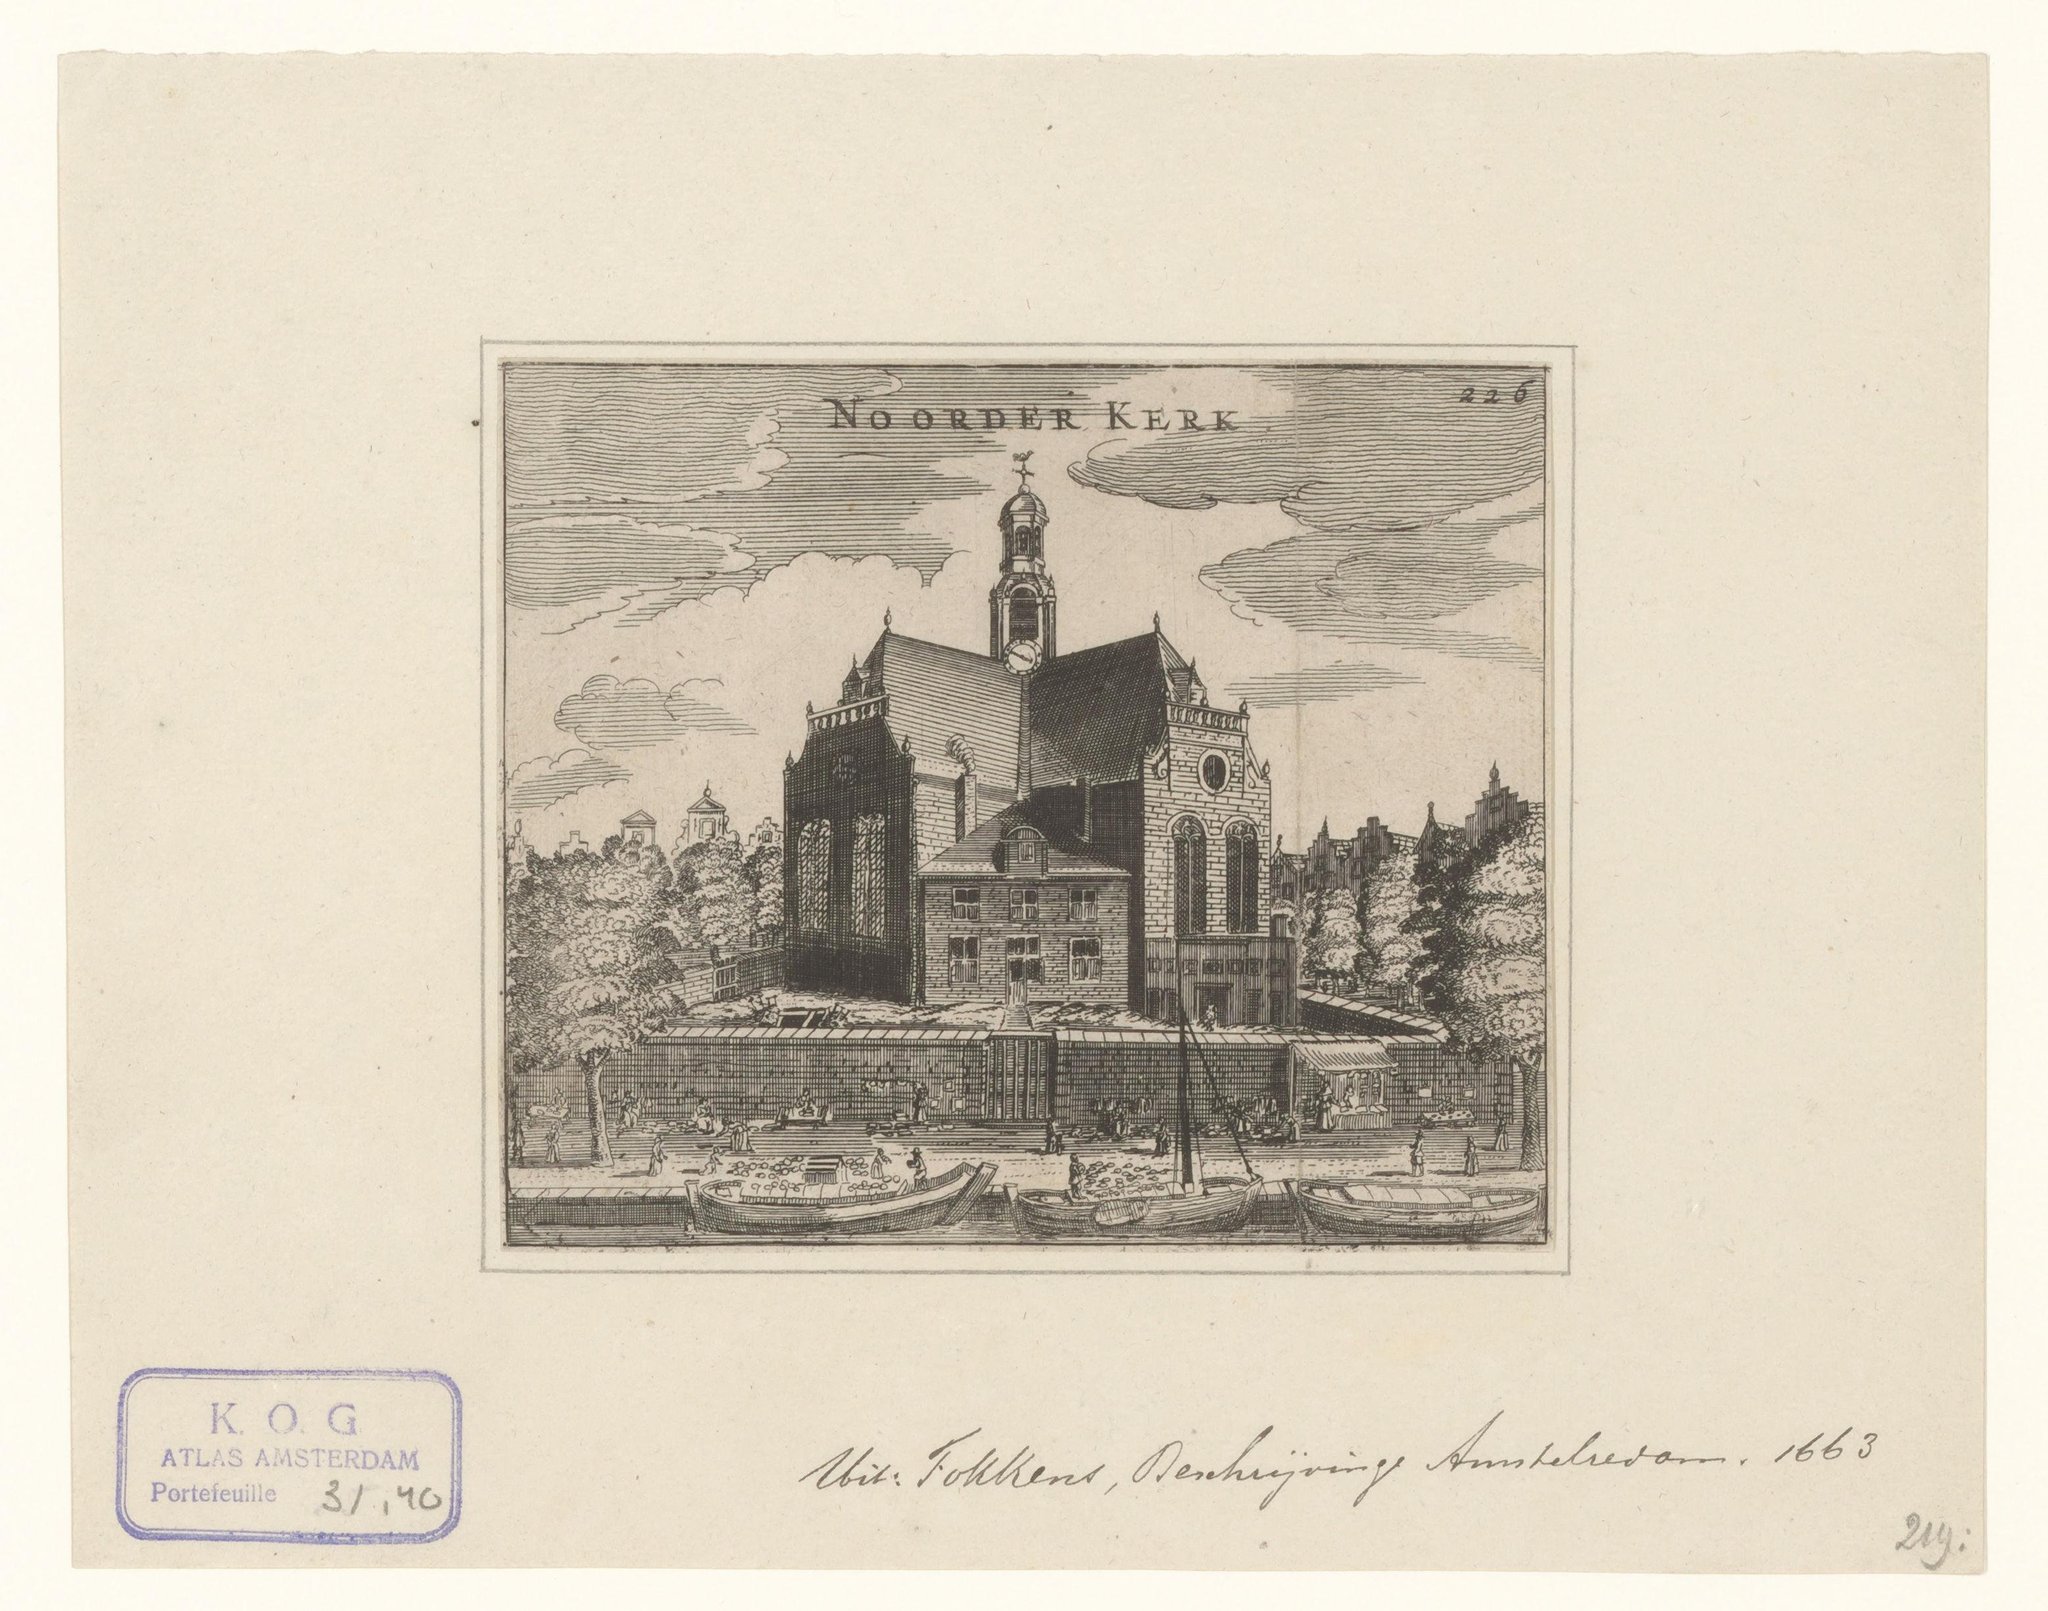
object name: print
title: Noorder Kerk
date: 1663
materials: paper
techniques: engraving, etching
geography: amsterdam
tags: ships (in general), church (exterior), market, canals, waters (in city) (+ city(-scape) with figures, staffage)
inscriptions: collector's mark: Lugt 1641b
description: Prent mogelijk uit: Fockens, Melchior. Beschrijvinge Der wijdt-vermaarde Koop-stadt Amstelredam (…). 2de druk. Amsterdam: Abraham (II) de Wees en Jan de Wees, 1663.